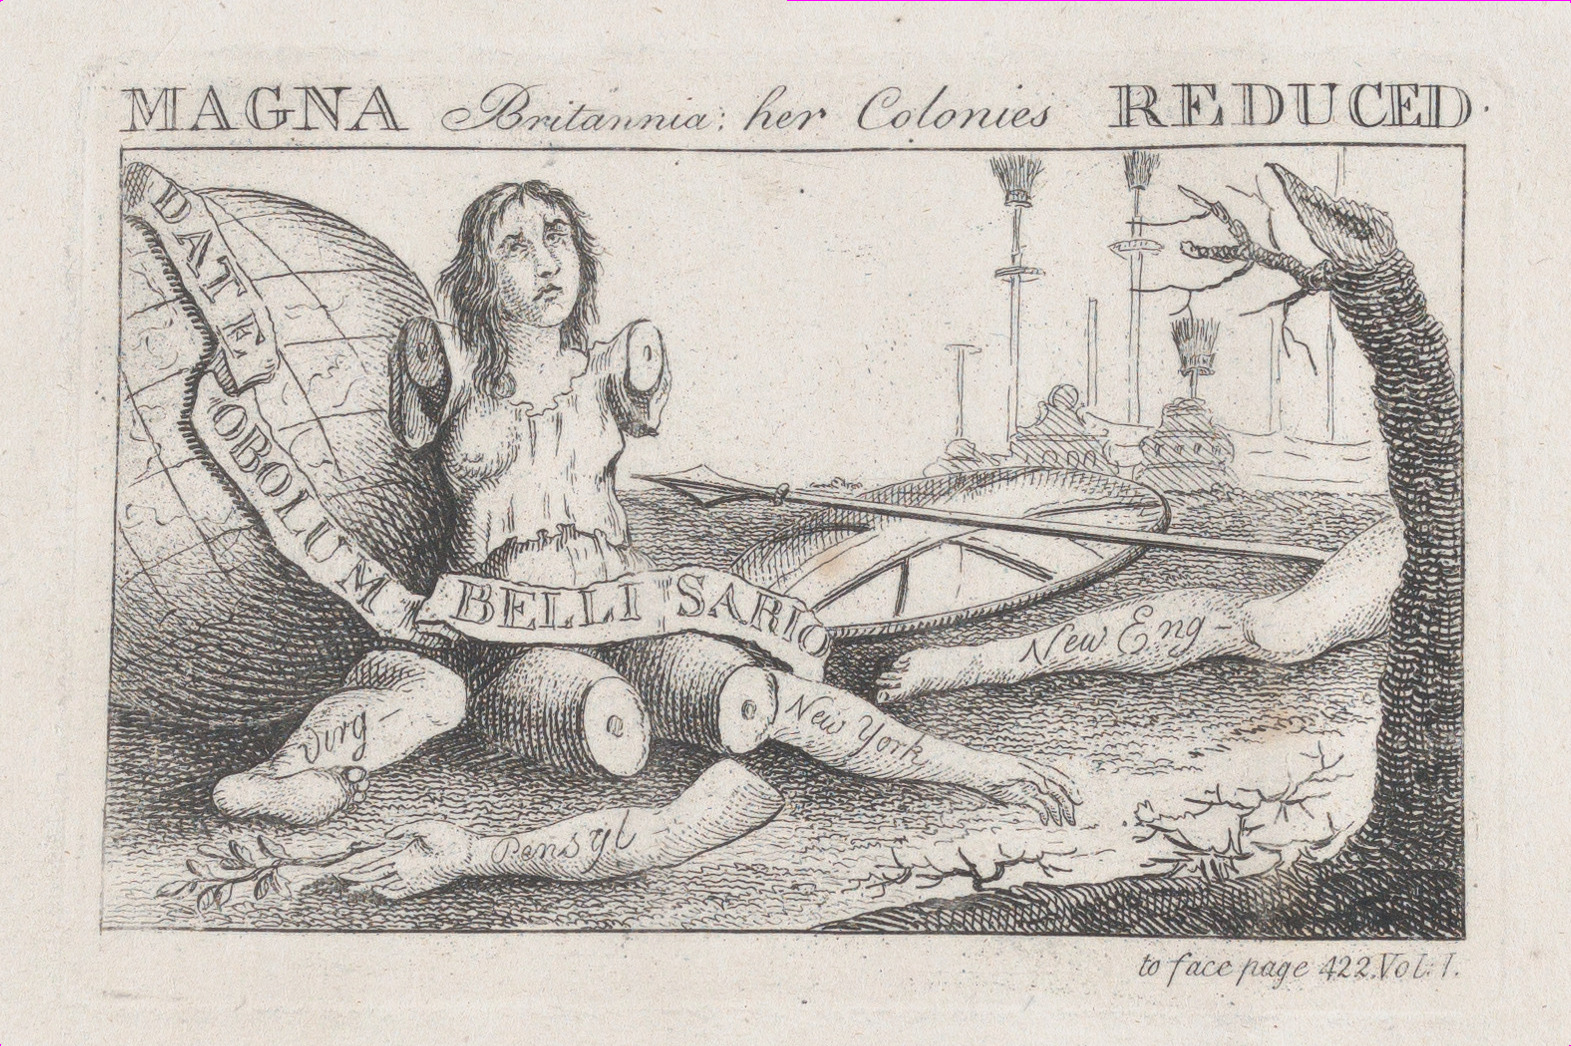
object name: print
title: Magna Britannia: Her Colonies Reduced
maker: benjamin franklin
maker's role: designer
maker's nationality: american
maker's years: 1706-1790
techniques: engraving, etching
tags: satire,american revolution,politics